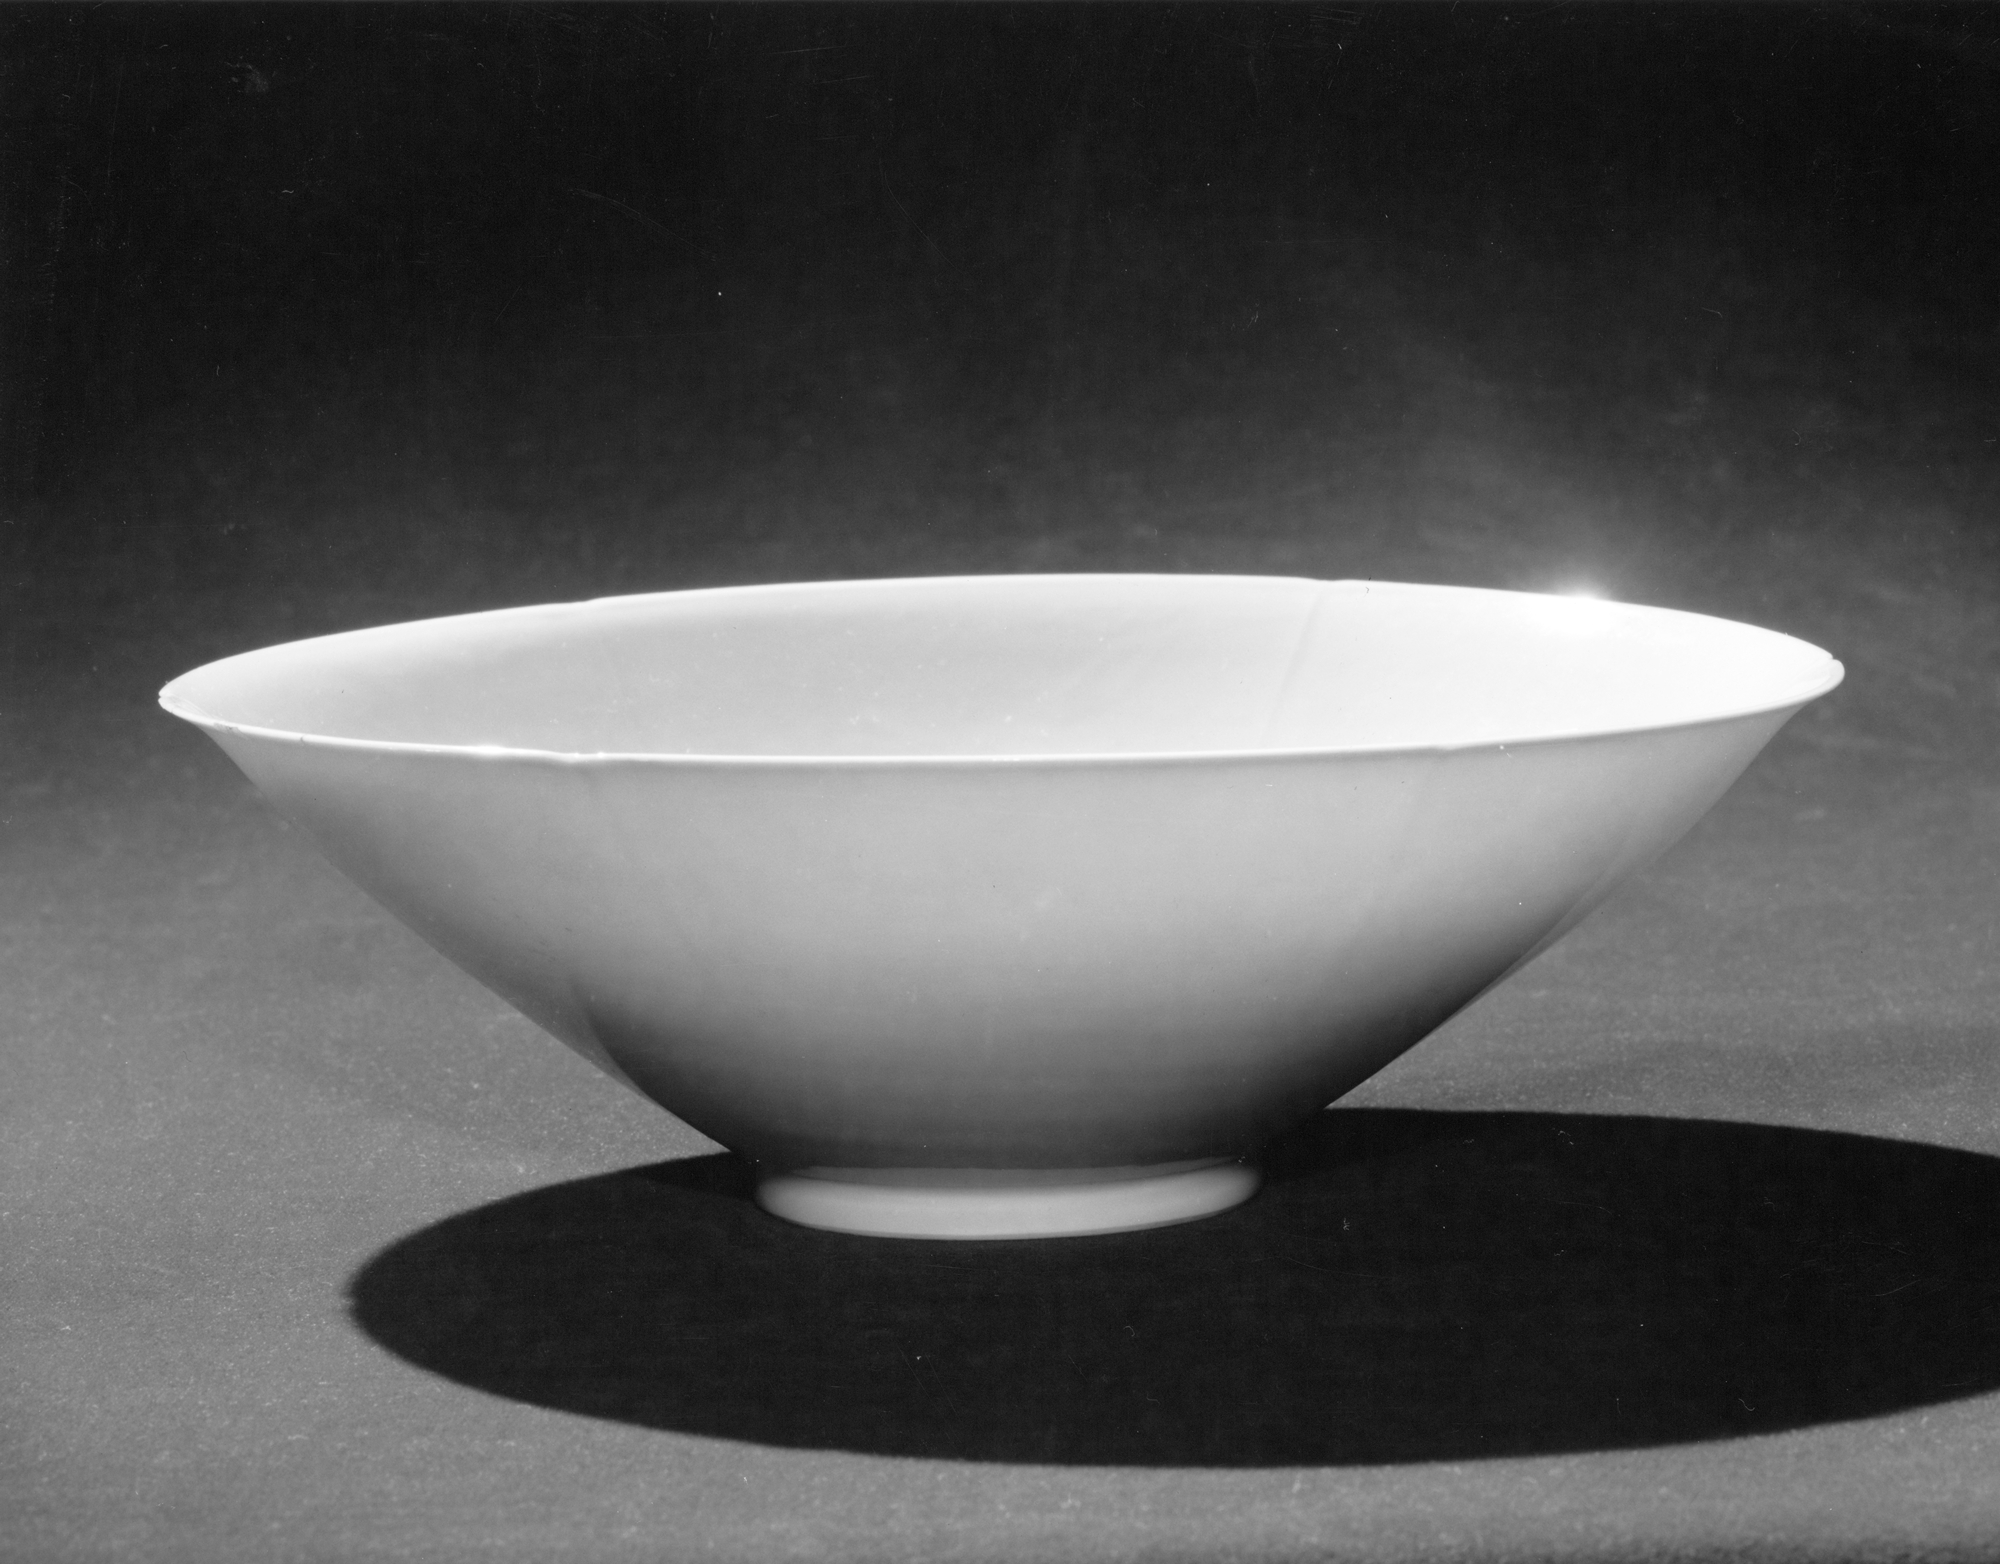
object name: bowl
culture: chinese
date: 1701-1733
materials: porcelain